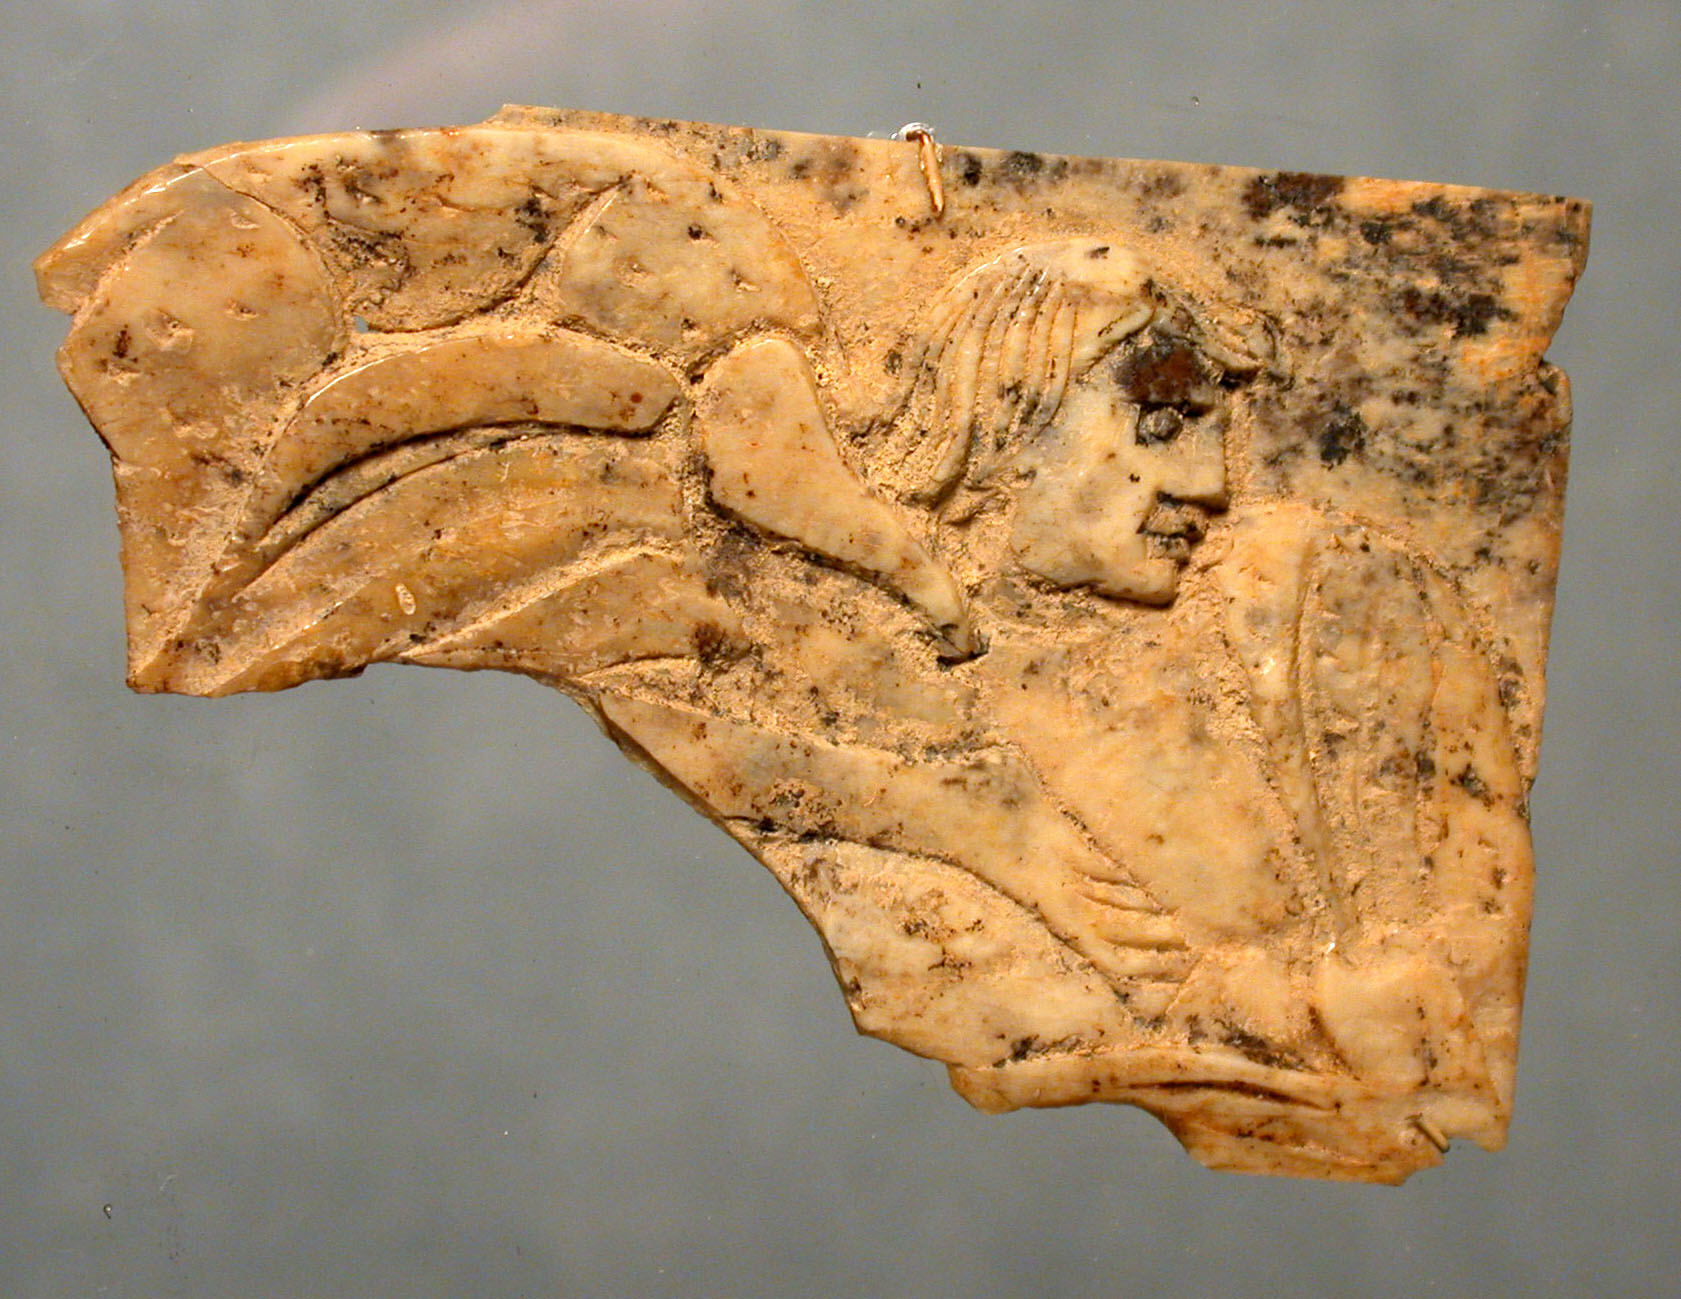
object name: plaque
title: Plaque of a Young Man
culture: egyptian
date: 201-400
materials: bone